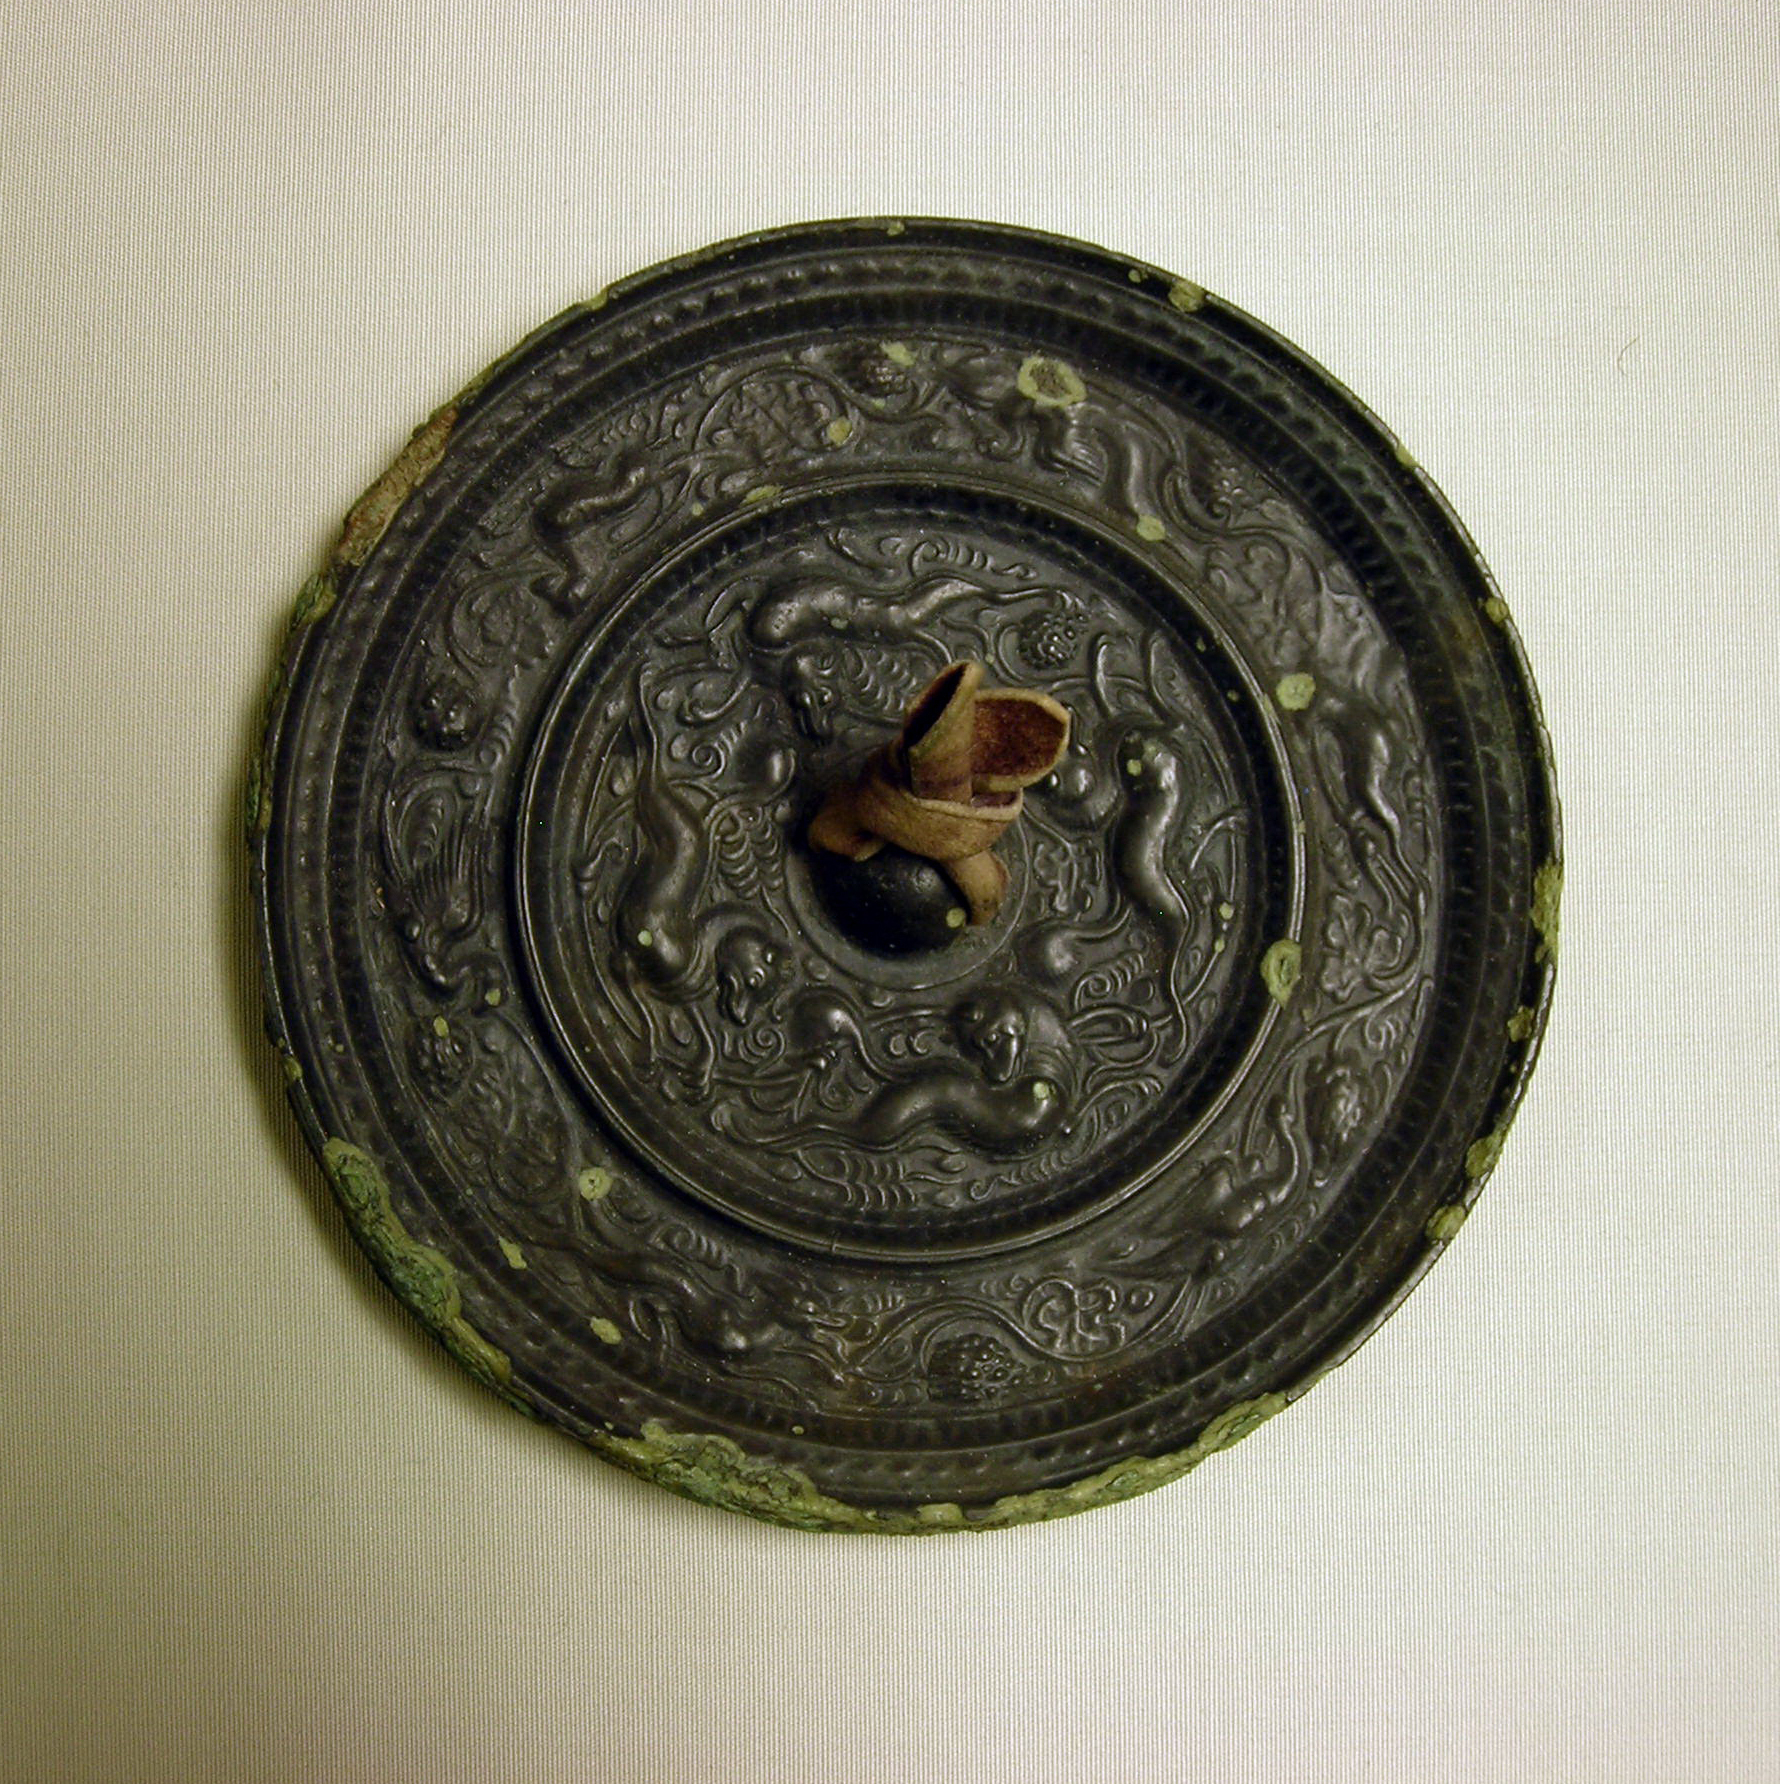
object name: mirror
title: Mirror with fantastic animals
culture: chinese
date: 601-800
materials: bronze